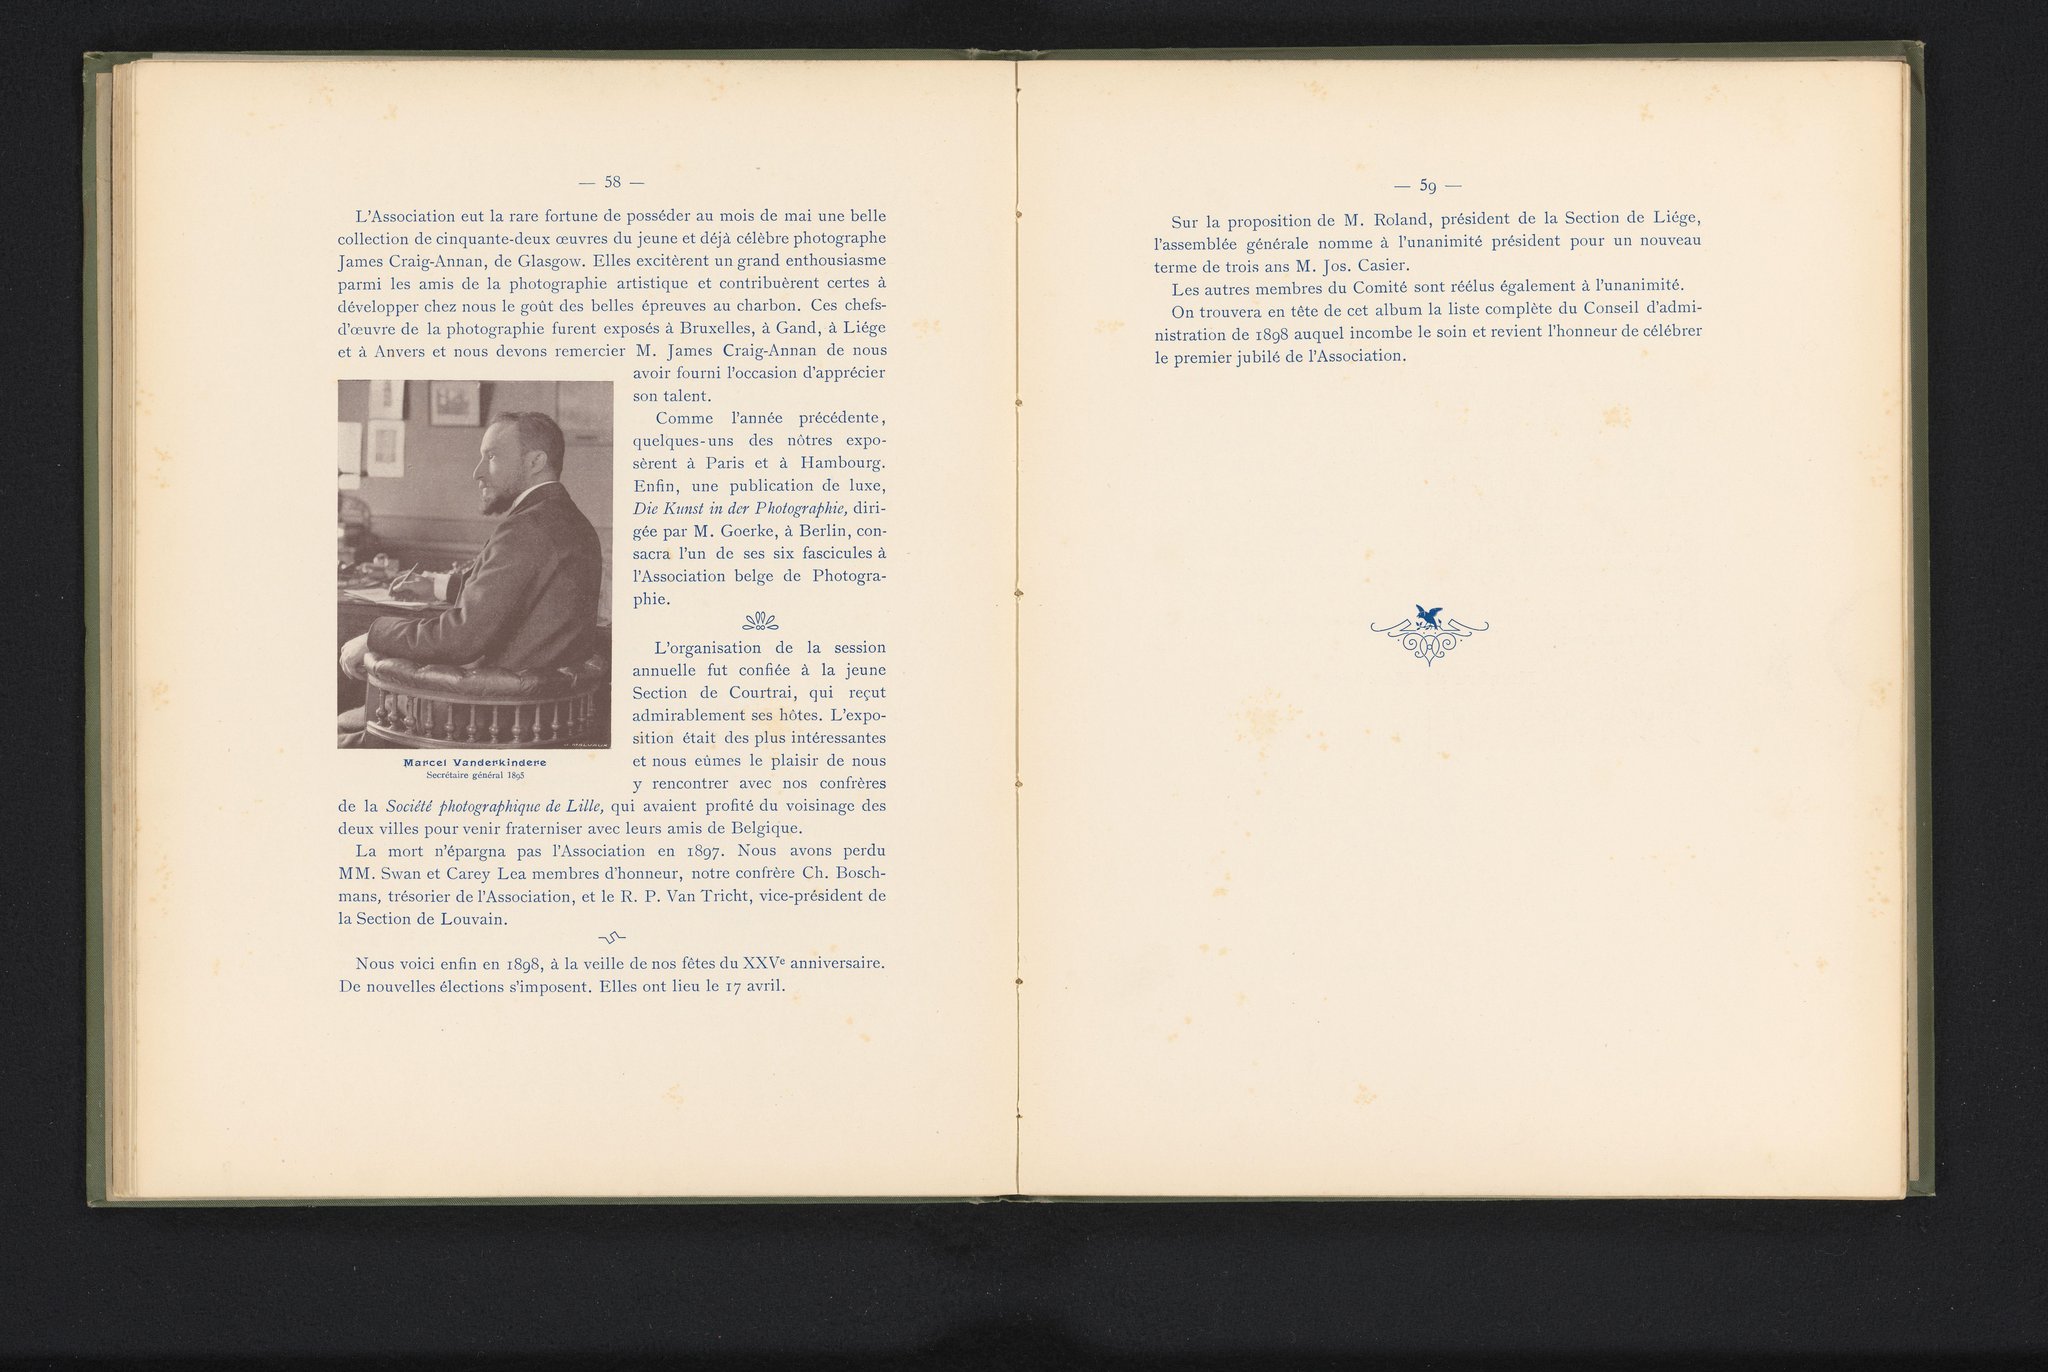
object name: photomechanical print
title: Portret van Marcel Vanderkindere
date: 1893-1898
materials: paper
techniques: autotype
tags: brussels, marcel vanderkindere, historical persons